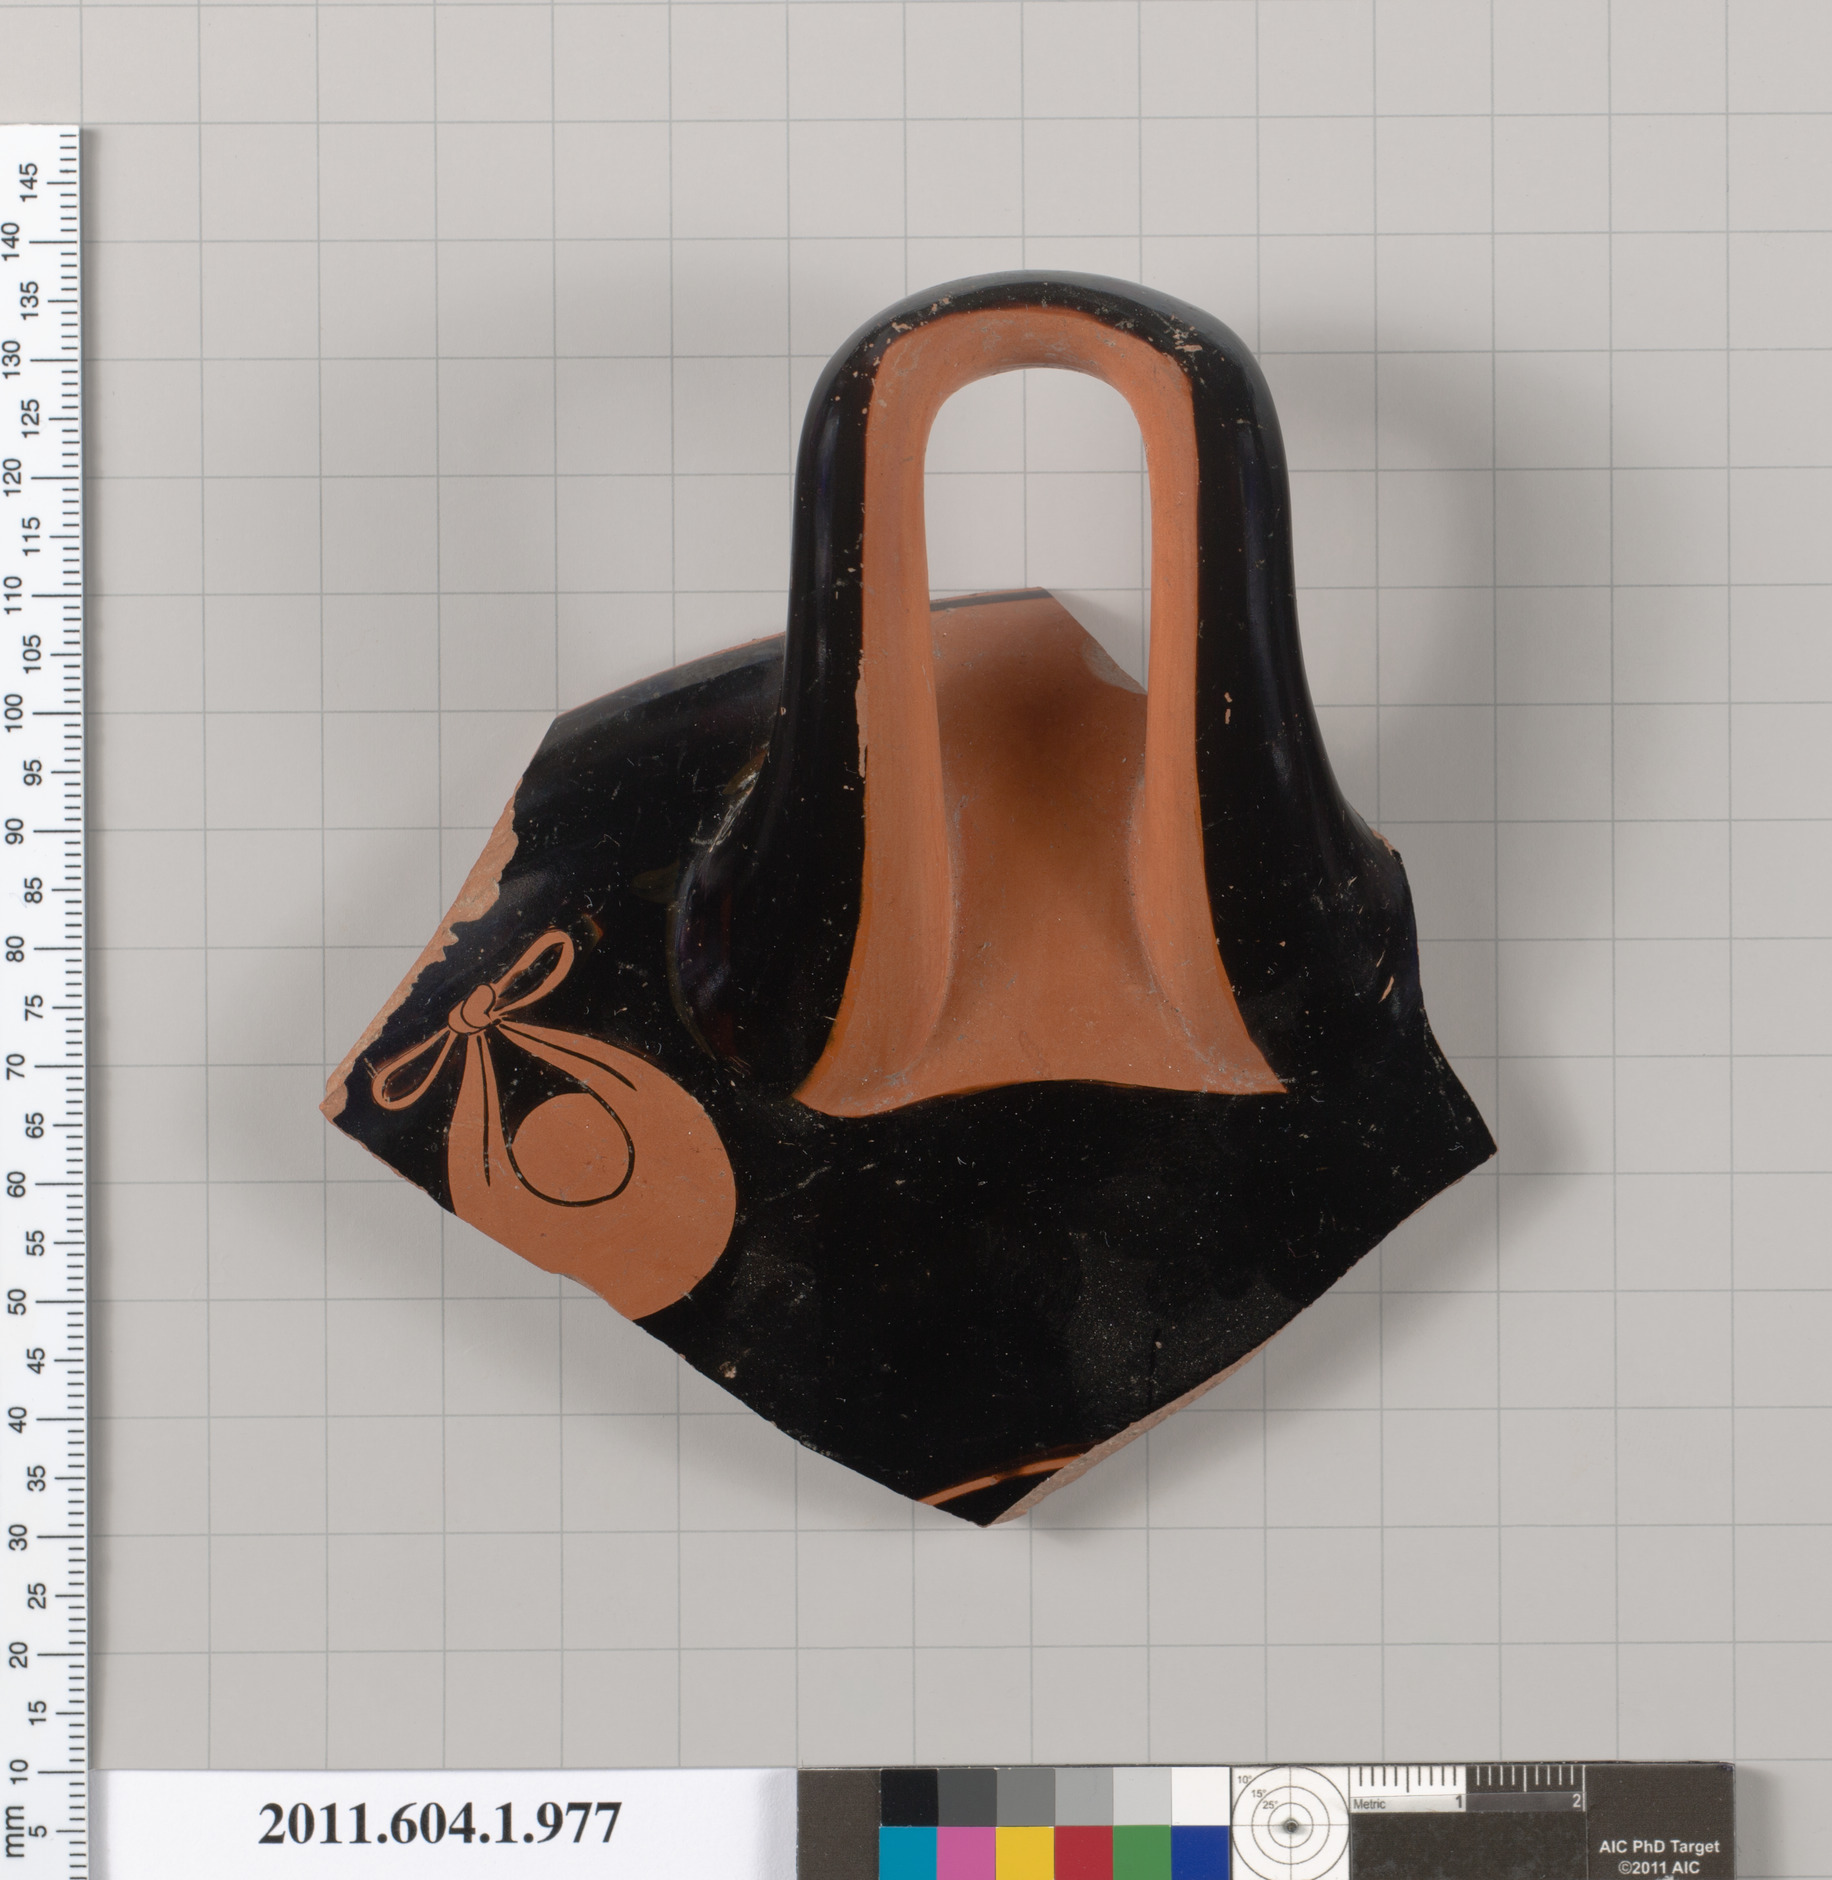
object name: kylix fragment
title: Terracotta fragment of a kylix (drinking cup)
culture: greek, attic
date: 490-480 BCE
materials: terracotta